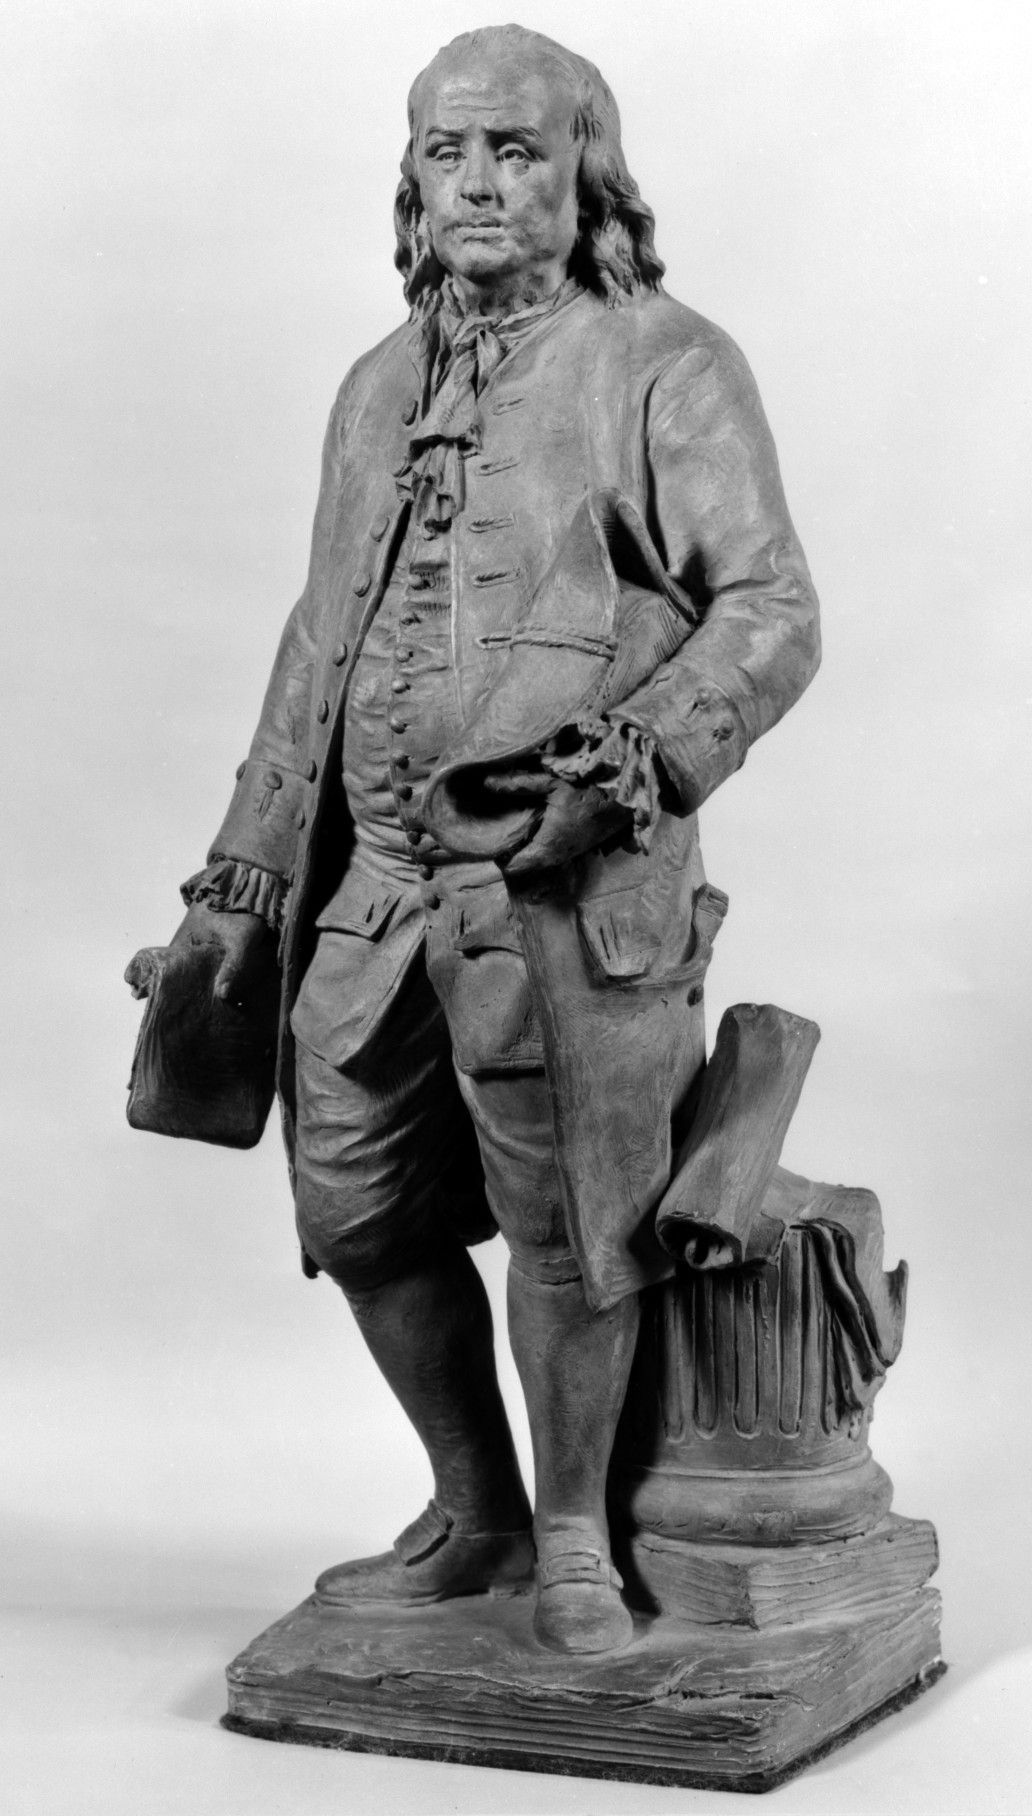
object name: statuette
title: Benjamin Franklin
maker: françois marie suzanne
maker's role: artist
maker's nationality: french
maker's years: 1751-1802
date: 1767-1800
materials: terracotta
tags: benjamin franklin